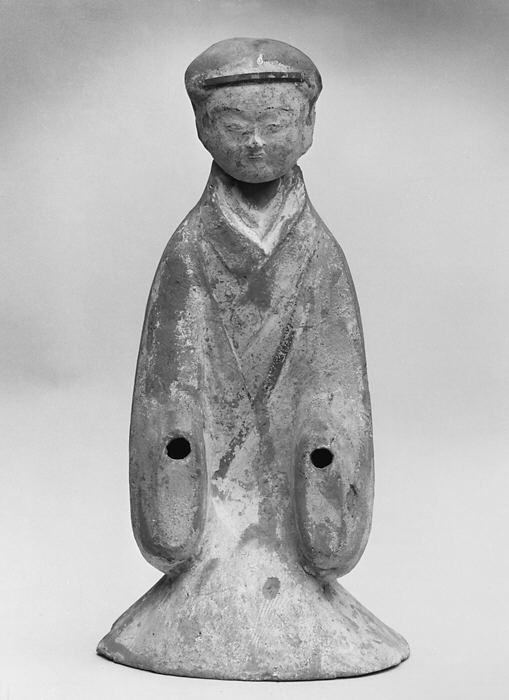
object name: figure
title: Figure with Removable Head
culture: chinese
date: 206 BCE-220 CE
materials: pottery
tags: human figures